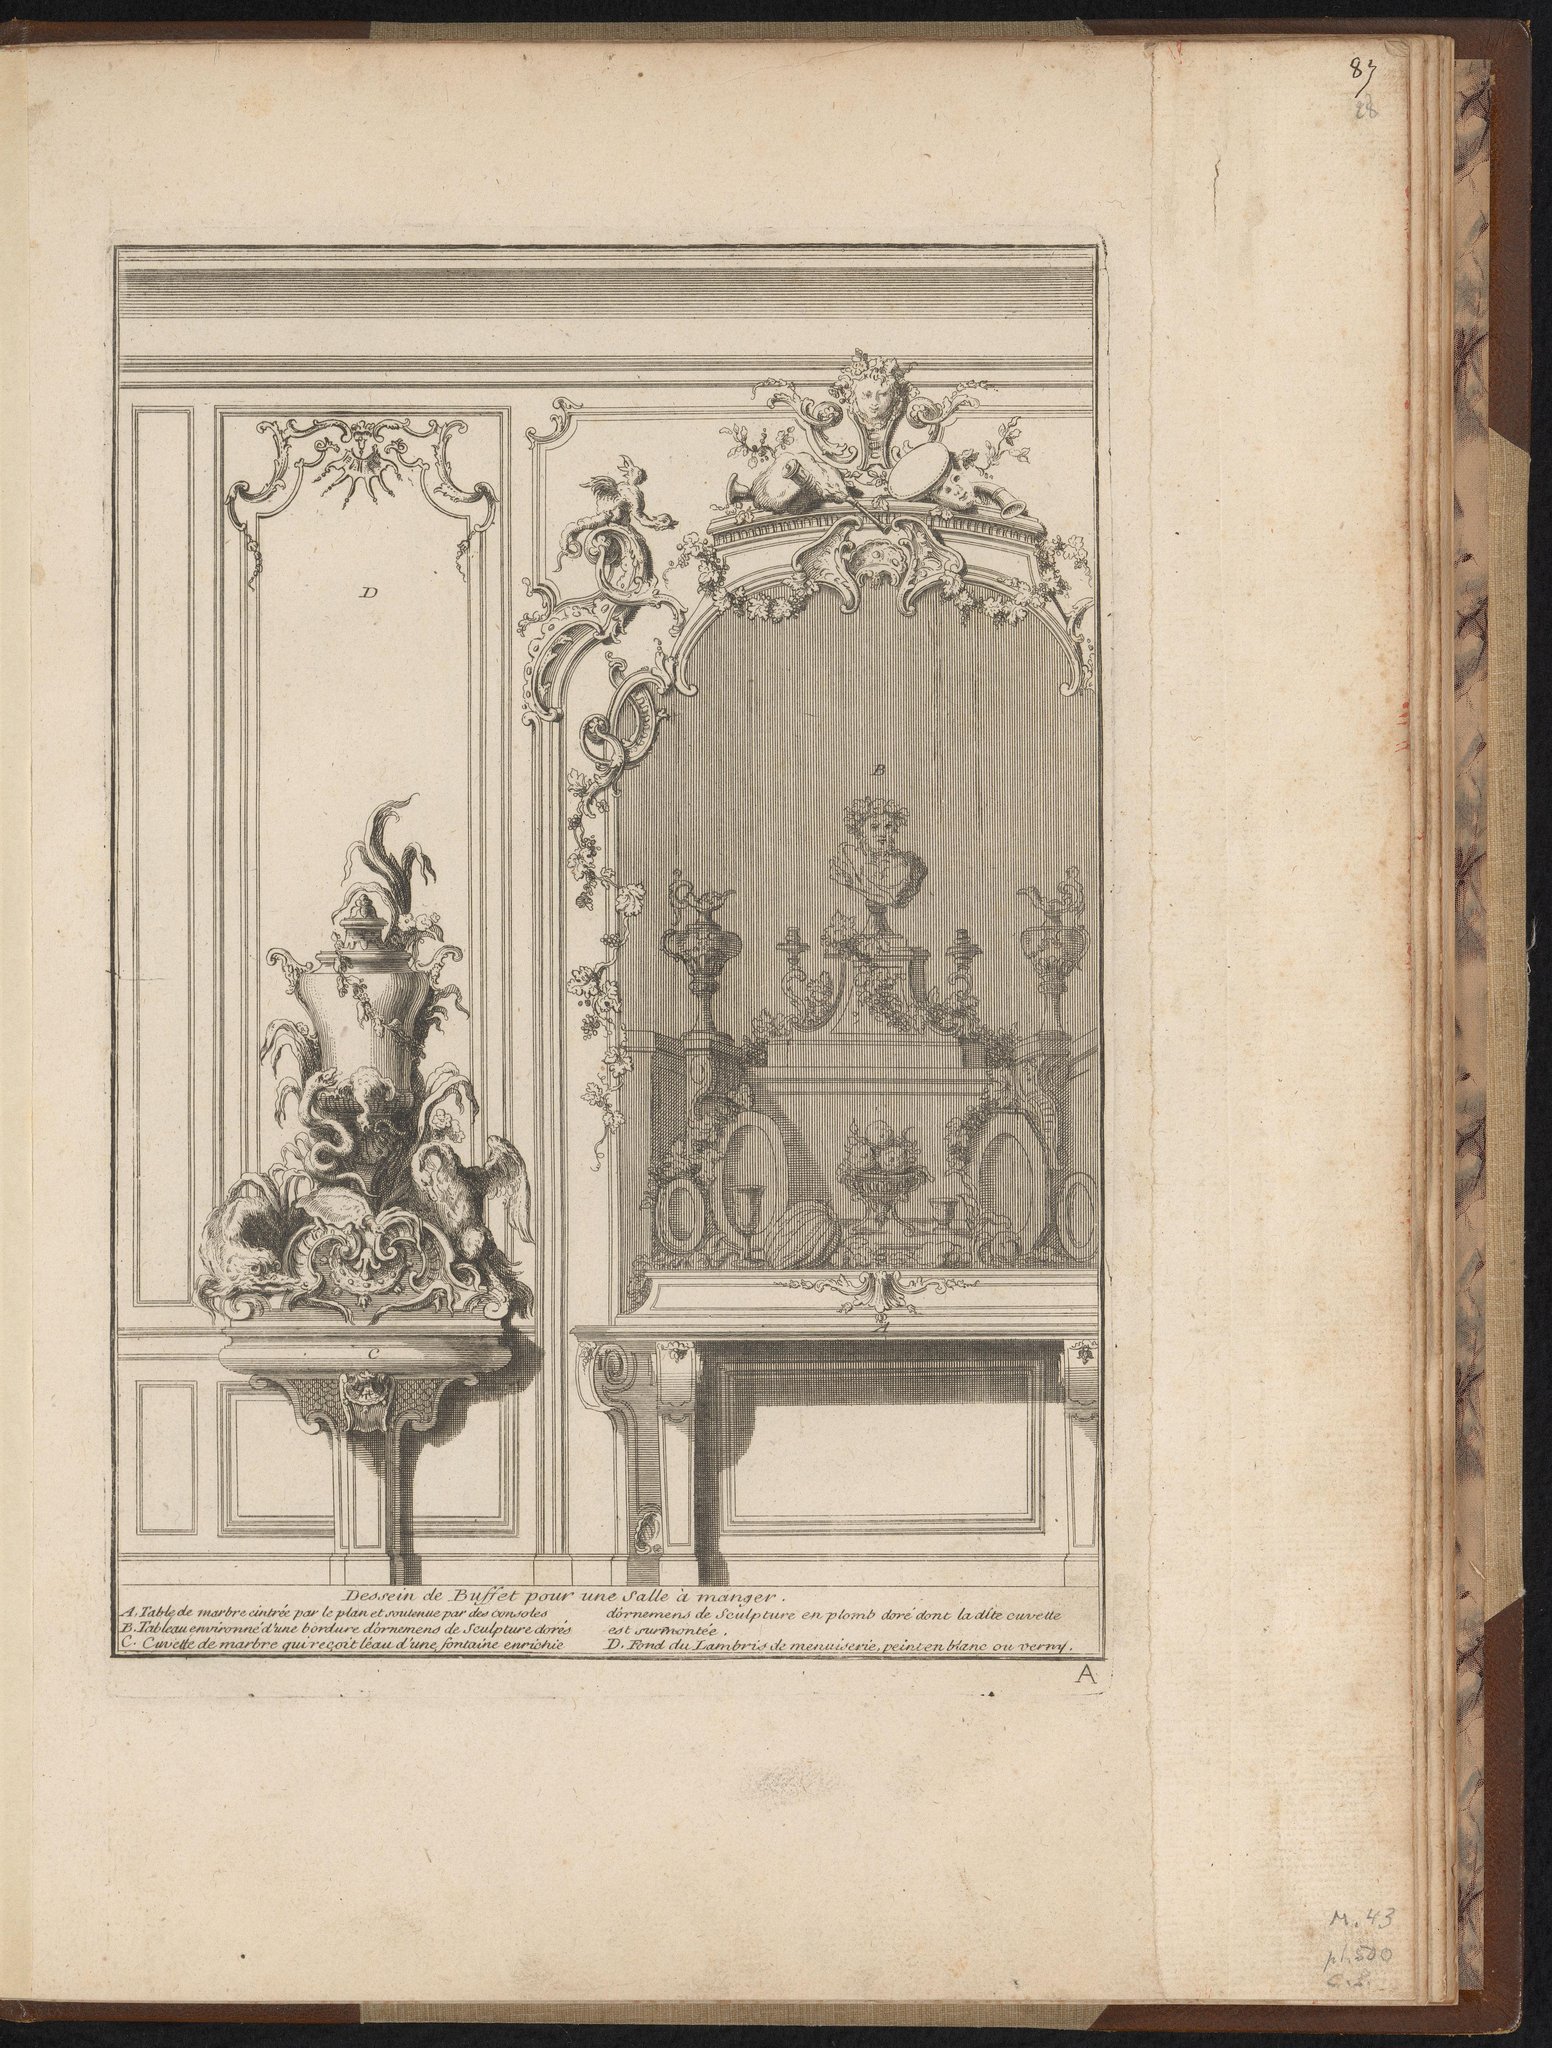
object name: album leaf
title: Ontwerp voor het interieur van een eetkamer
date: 1725-1750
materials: paper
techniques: etching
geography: paris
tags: ornaments ~ art, panelling, dining-room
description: Variant in spiegelbeeld van RP-P-2003-474-35. Daarop staan zowel Pineau als Mariette vermeld.